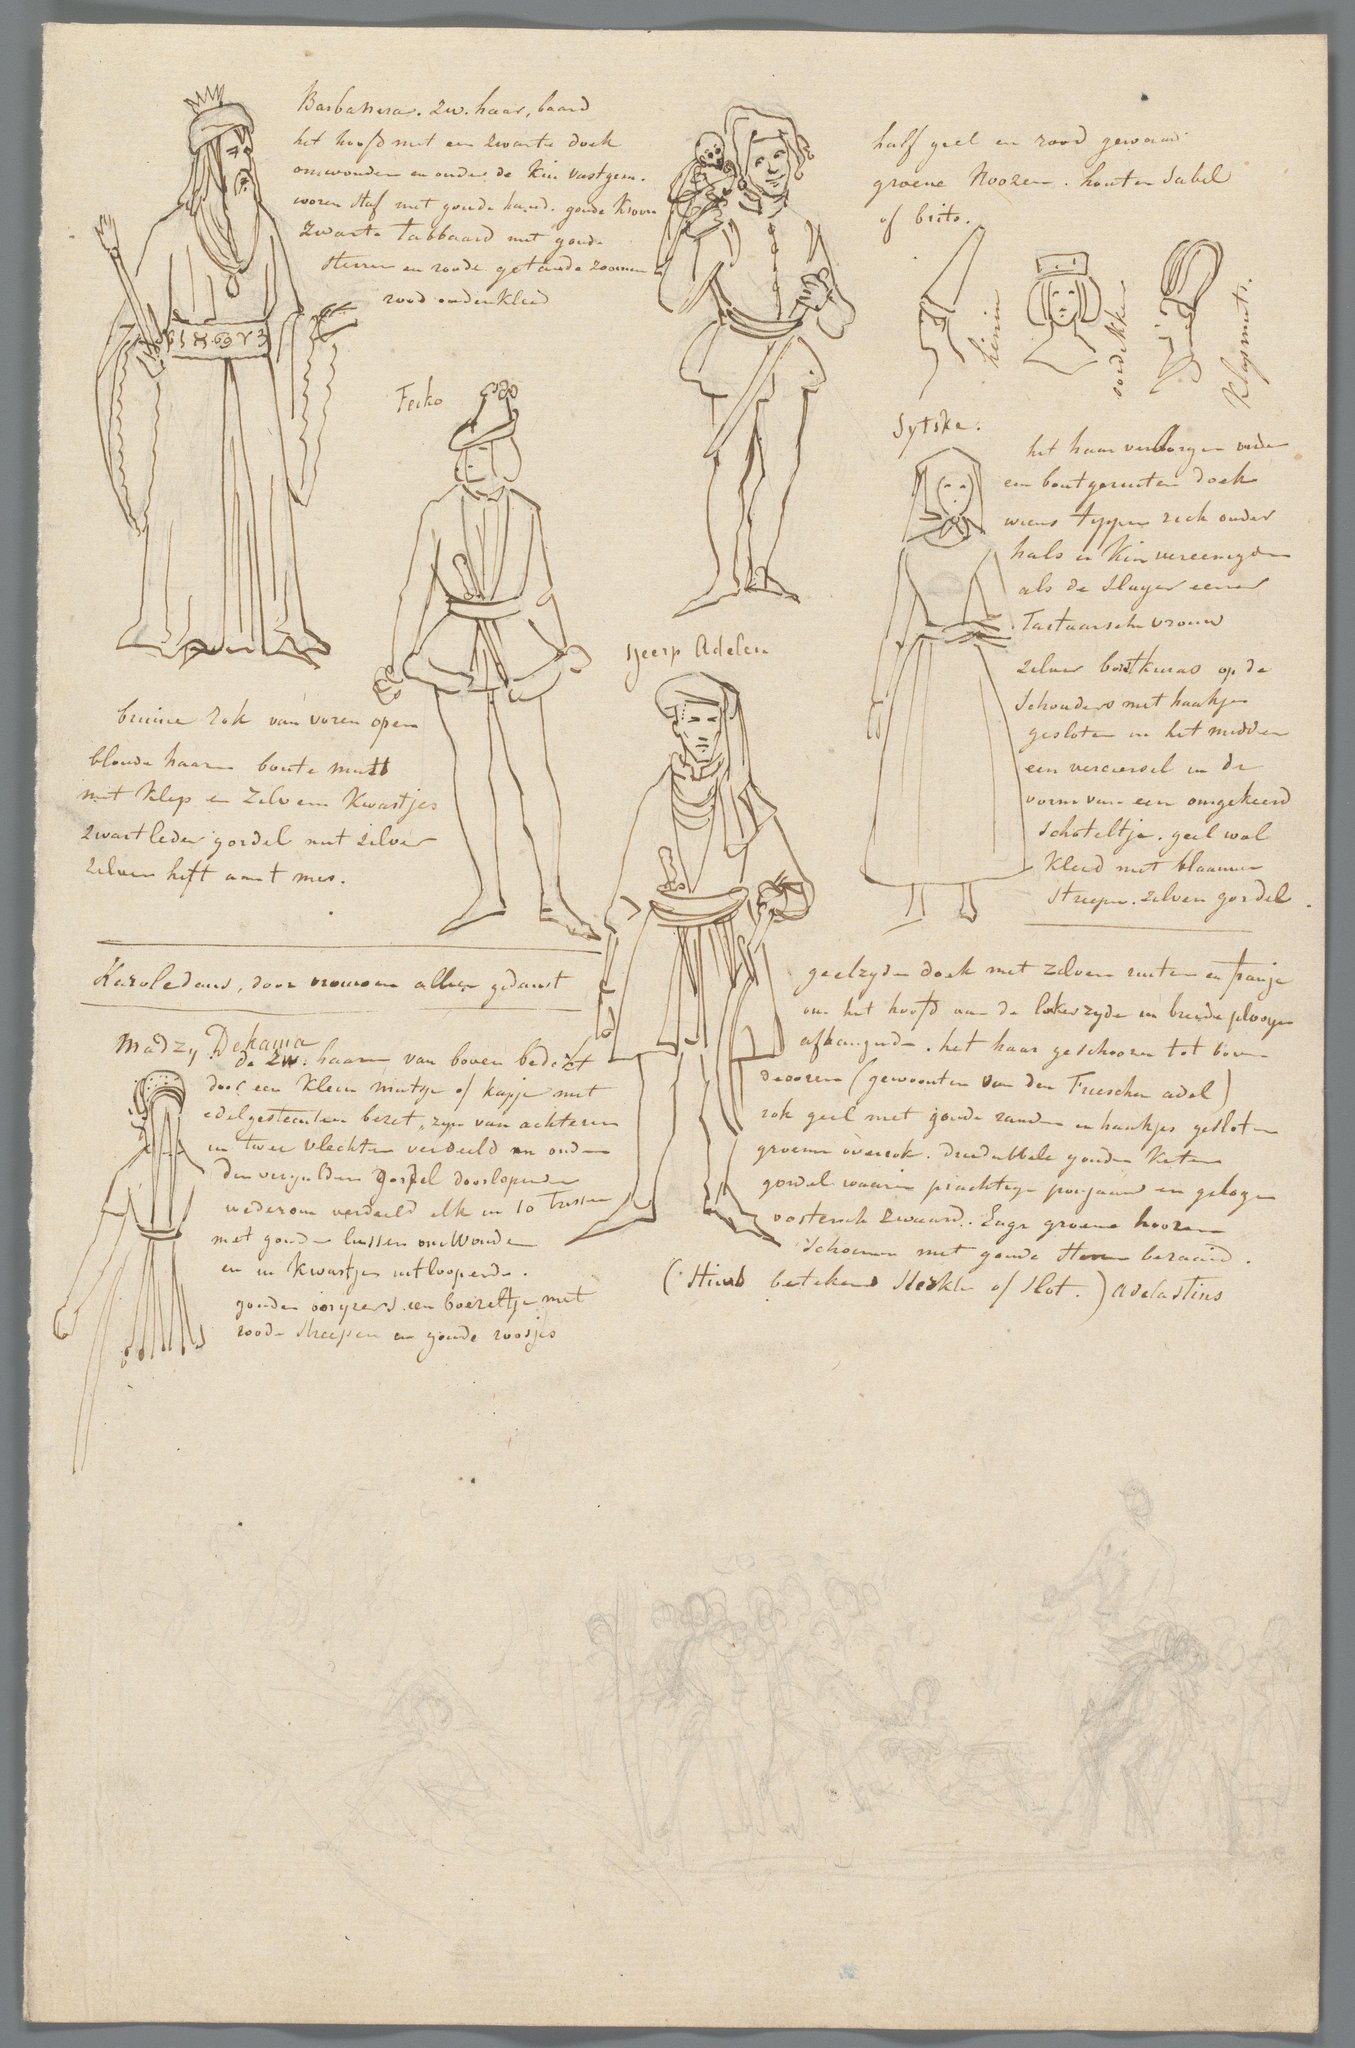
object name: drawing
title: Kostuums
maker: jacobus everhardus josephus van den berg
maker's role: draughtsman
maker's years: 1802-1861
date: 1812-1861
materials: ink, paper, pencil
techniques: pen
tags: clothes, costume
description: Mogelijk kostuums voor een toneelstuk. Met handgeschreven tekst met de naam van de afgebeelde figuur en een beschrijving van de kleuren en details van de kostuums.